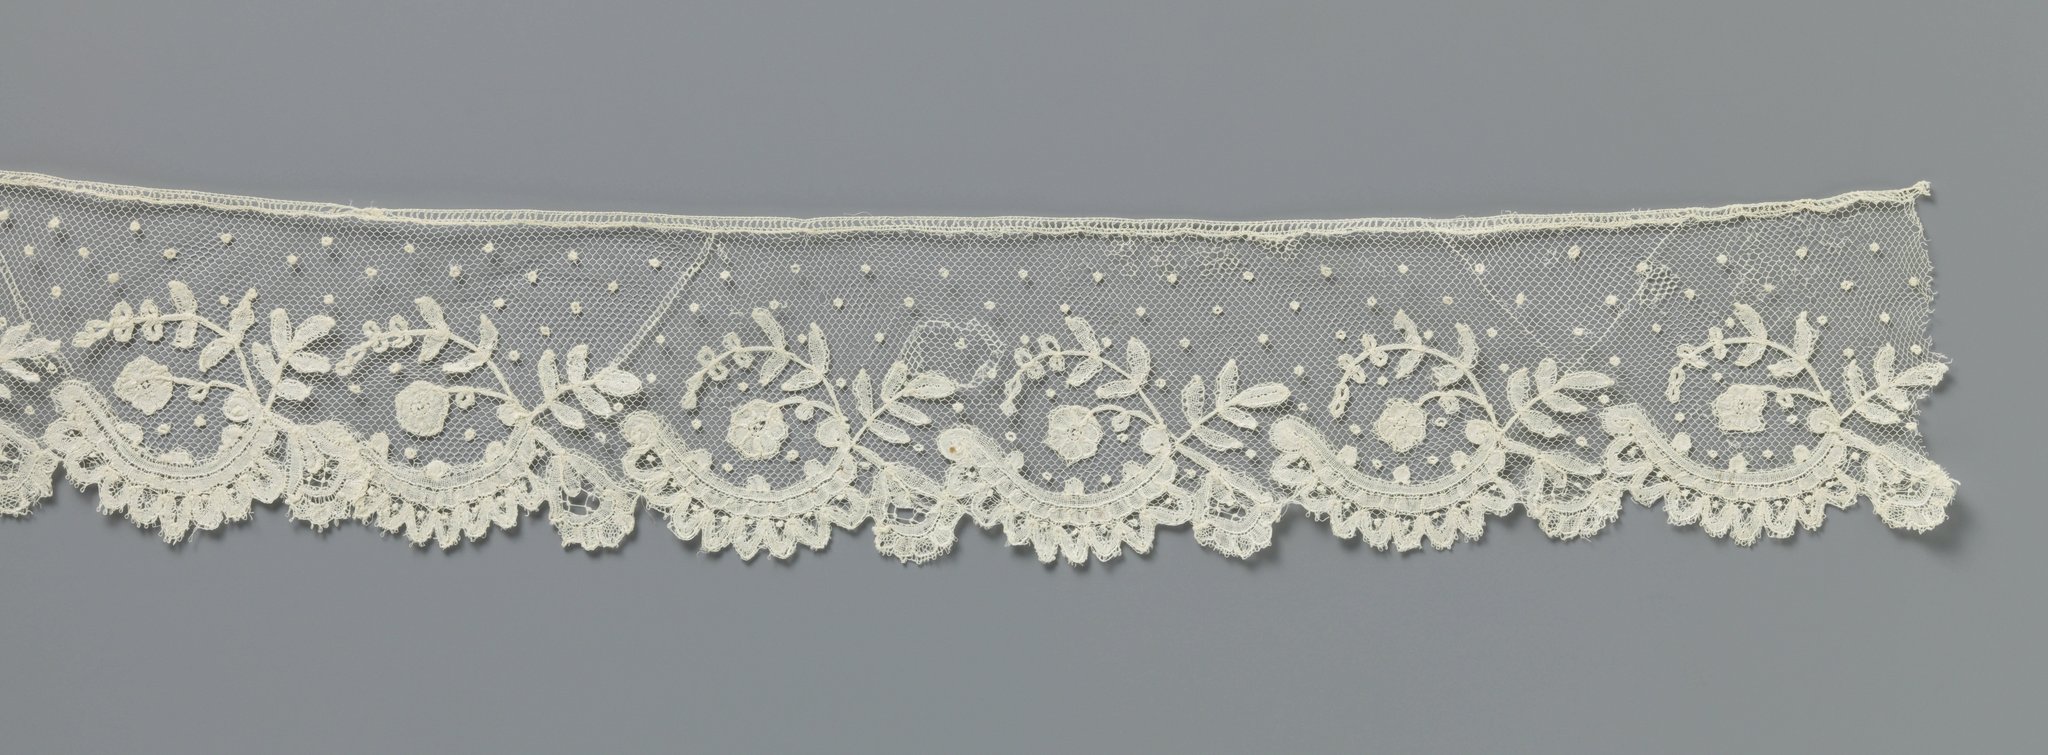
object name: strip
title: Strook applicatiekant met campanes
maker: Anonymous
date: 1890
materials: linen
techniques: lace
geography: brussels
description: Opmerking in inventaris Koningin Emma: 'gekocht van Frau Sutherland vóór 1894'. In het Koninklijk Huisarchief bevindt zich een foto van Koningin Emma, uit 1928, waarbij zij deze stroken als mouwversiering draagt (zie ook BK-BR-J-360, ook op deze foto).